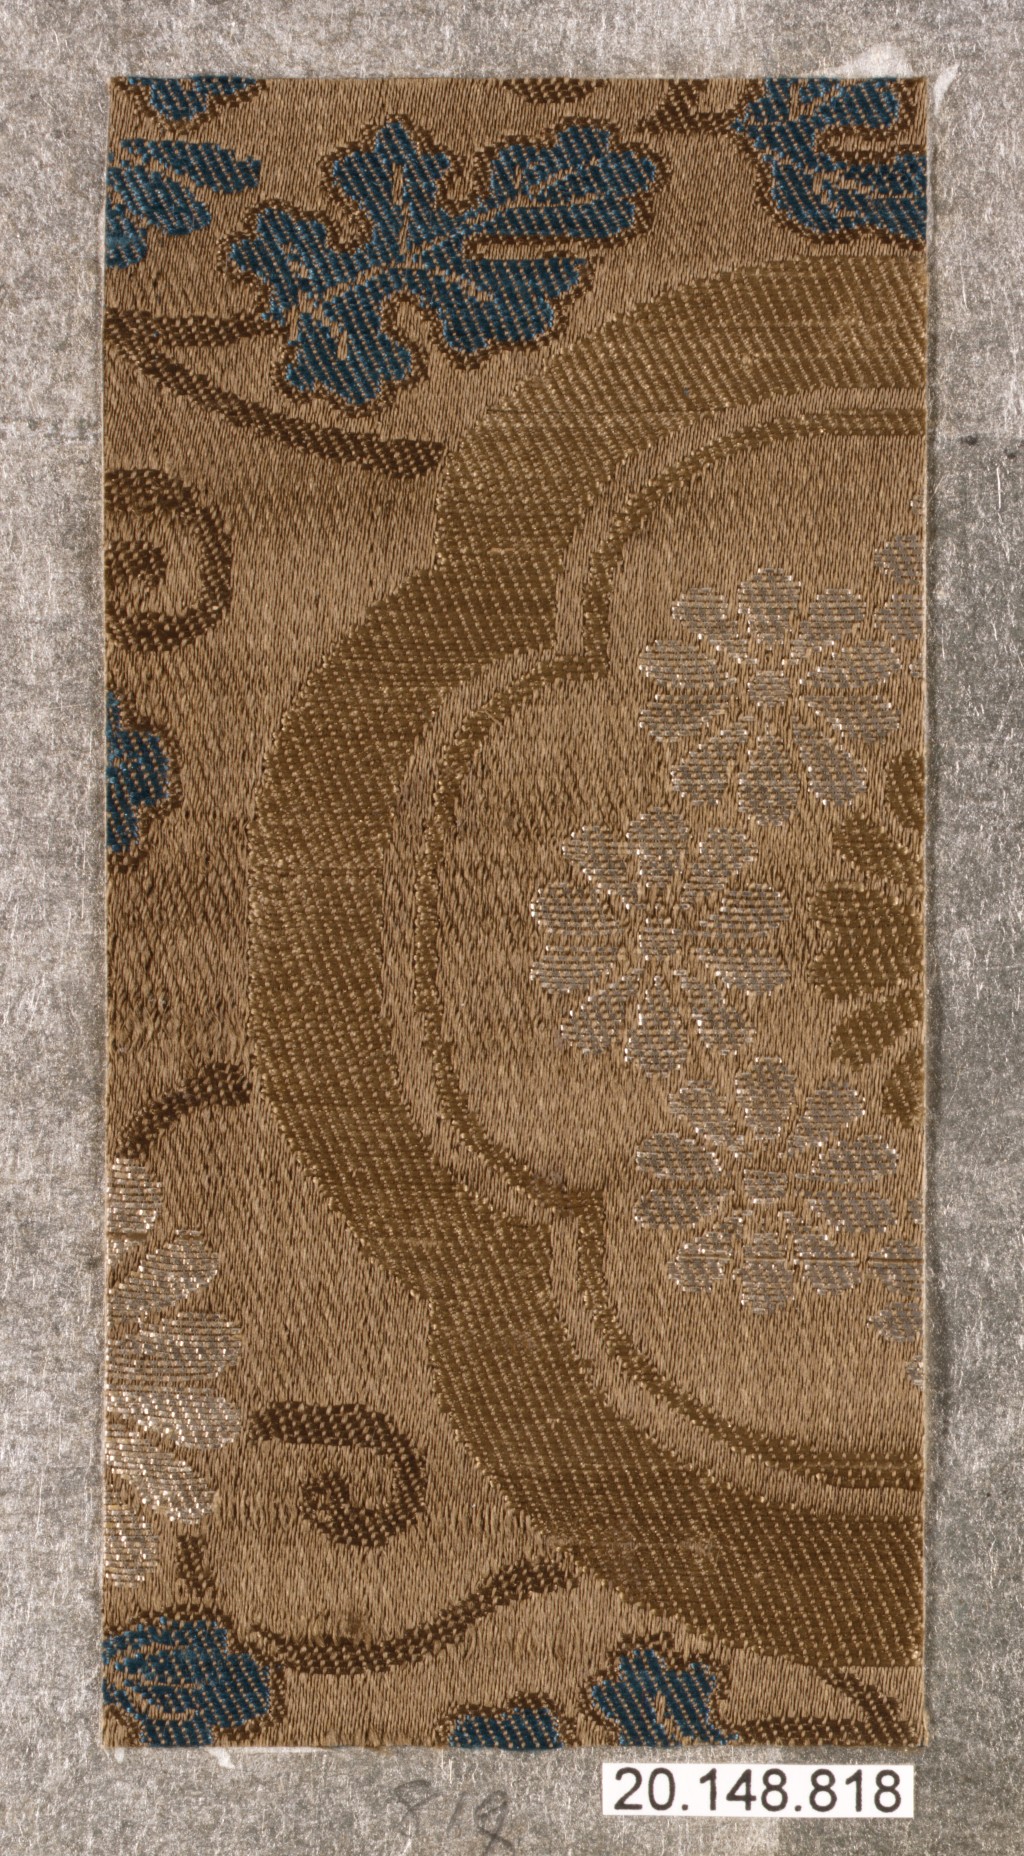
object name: piece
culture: japanese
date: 1701-1800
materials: silk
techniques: compound weave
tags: flowers